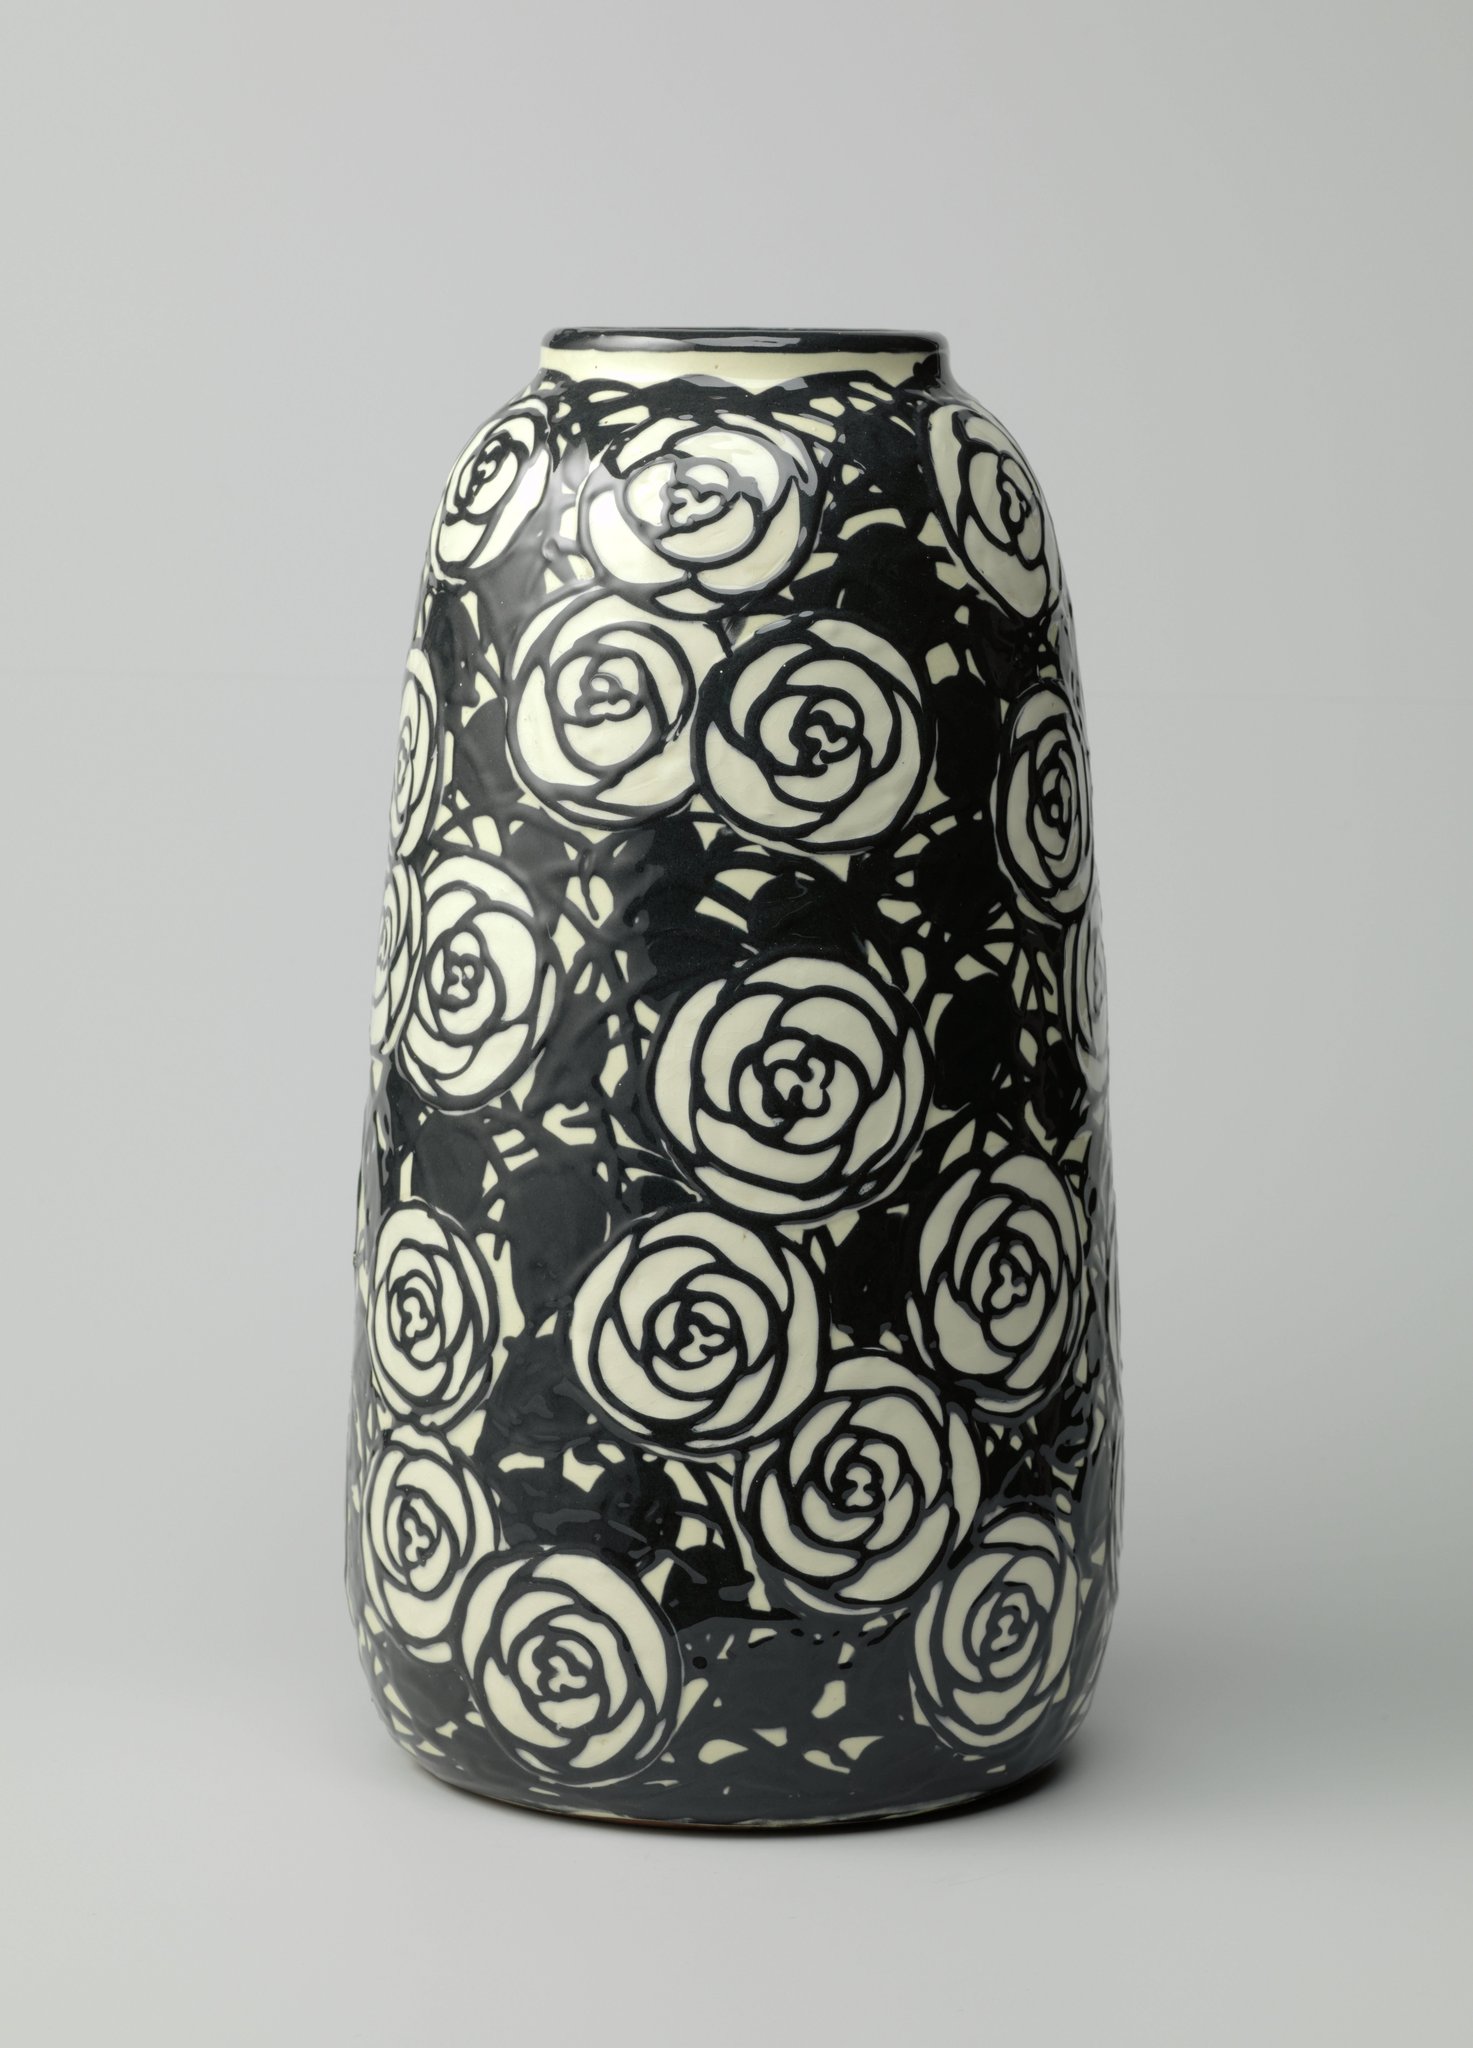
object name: vase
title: Vaas van aardewerk, versierd in reliëf met rozen en bladeren in zwart en wit op een geelwitte fond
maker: max laeuger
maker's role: ceramicist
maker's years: 1864-1952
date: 1910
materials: earthenware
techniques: slip technique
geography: karlsruhe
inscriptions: inscription: ‘Gesetzl. Geschzt’, stamp: ‘Muster Gesetzl. Geschtzt’, inscription: ‘512 4(?)’, factory mark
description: Vaas van aardewerk, versierd in reliëf, in slibtechniek, met een decor van rozen en bladeren in zwart en wit op geelwitte fond.